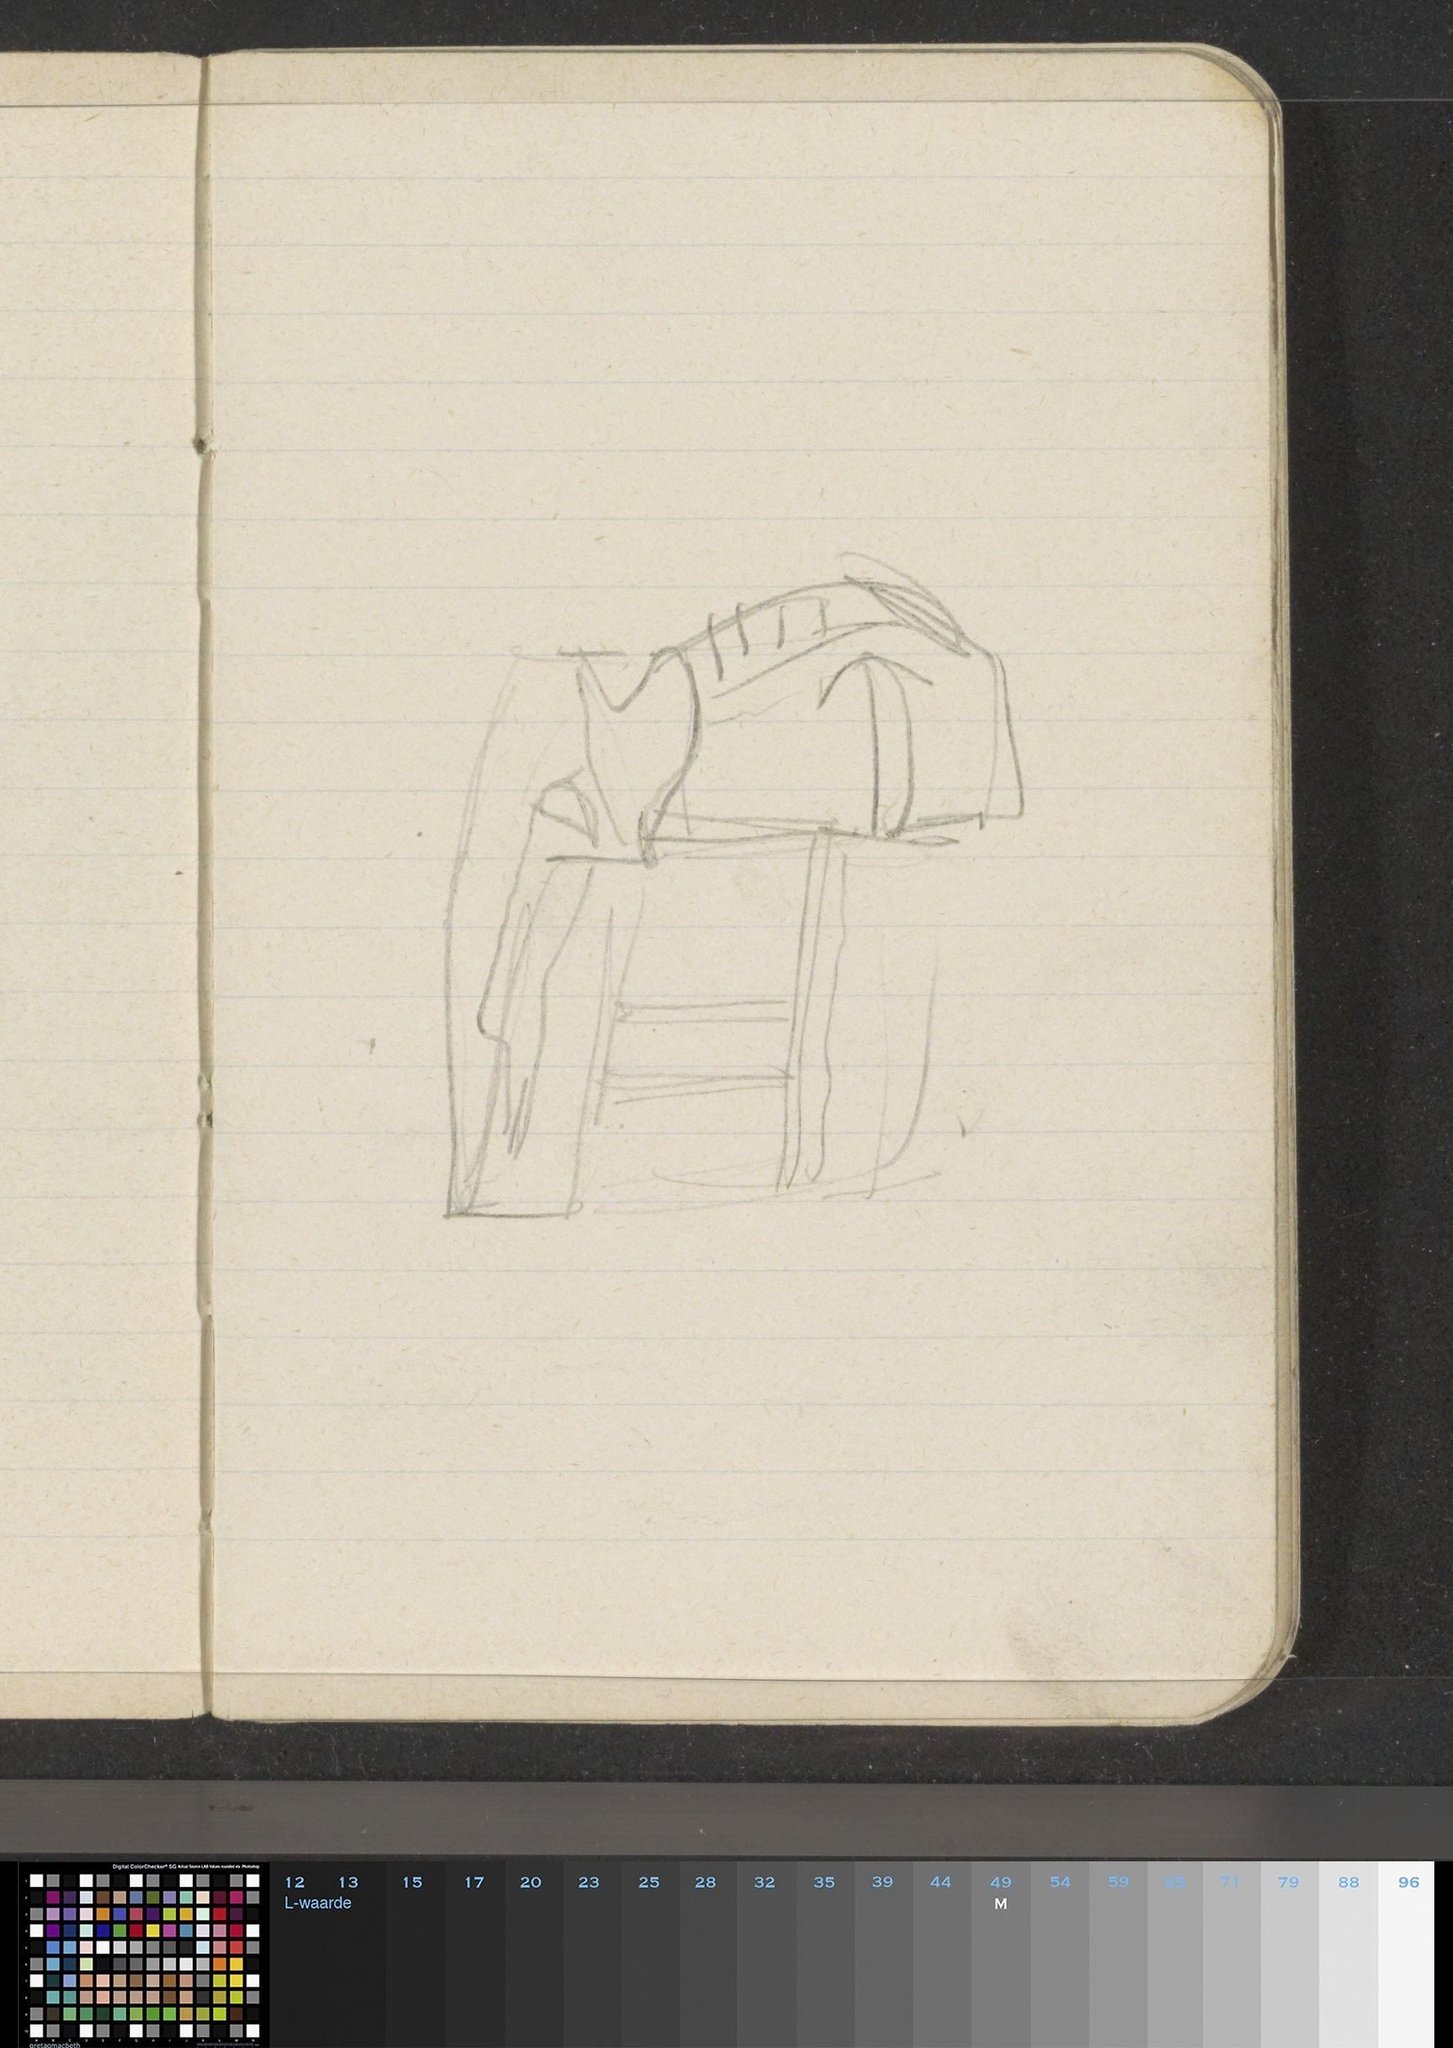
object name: sketchbook leaf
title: Studie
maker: george hendrik breitner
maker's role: draughtsman, painter, print maker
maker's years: 1857-1923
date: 1882-1885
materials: pencil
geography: amsterdam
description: Pagina 5 uit een schetsboek met 34 bladen.